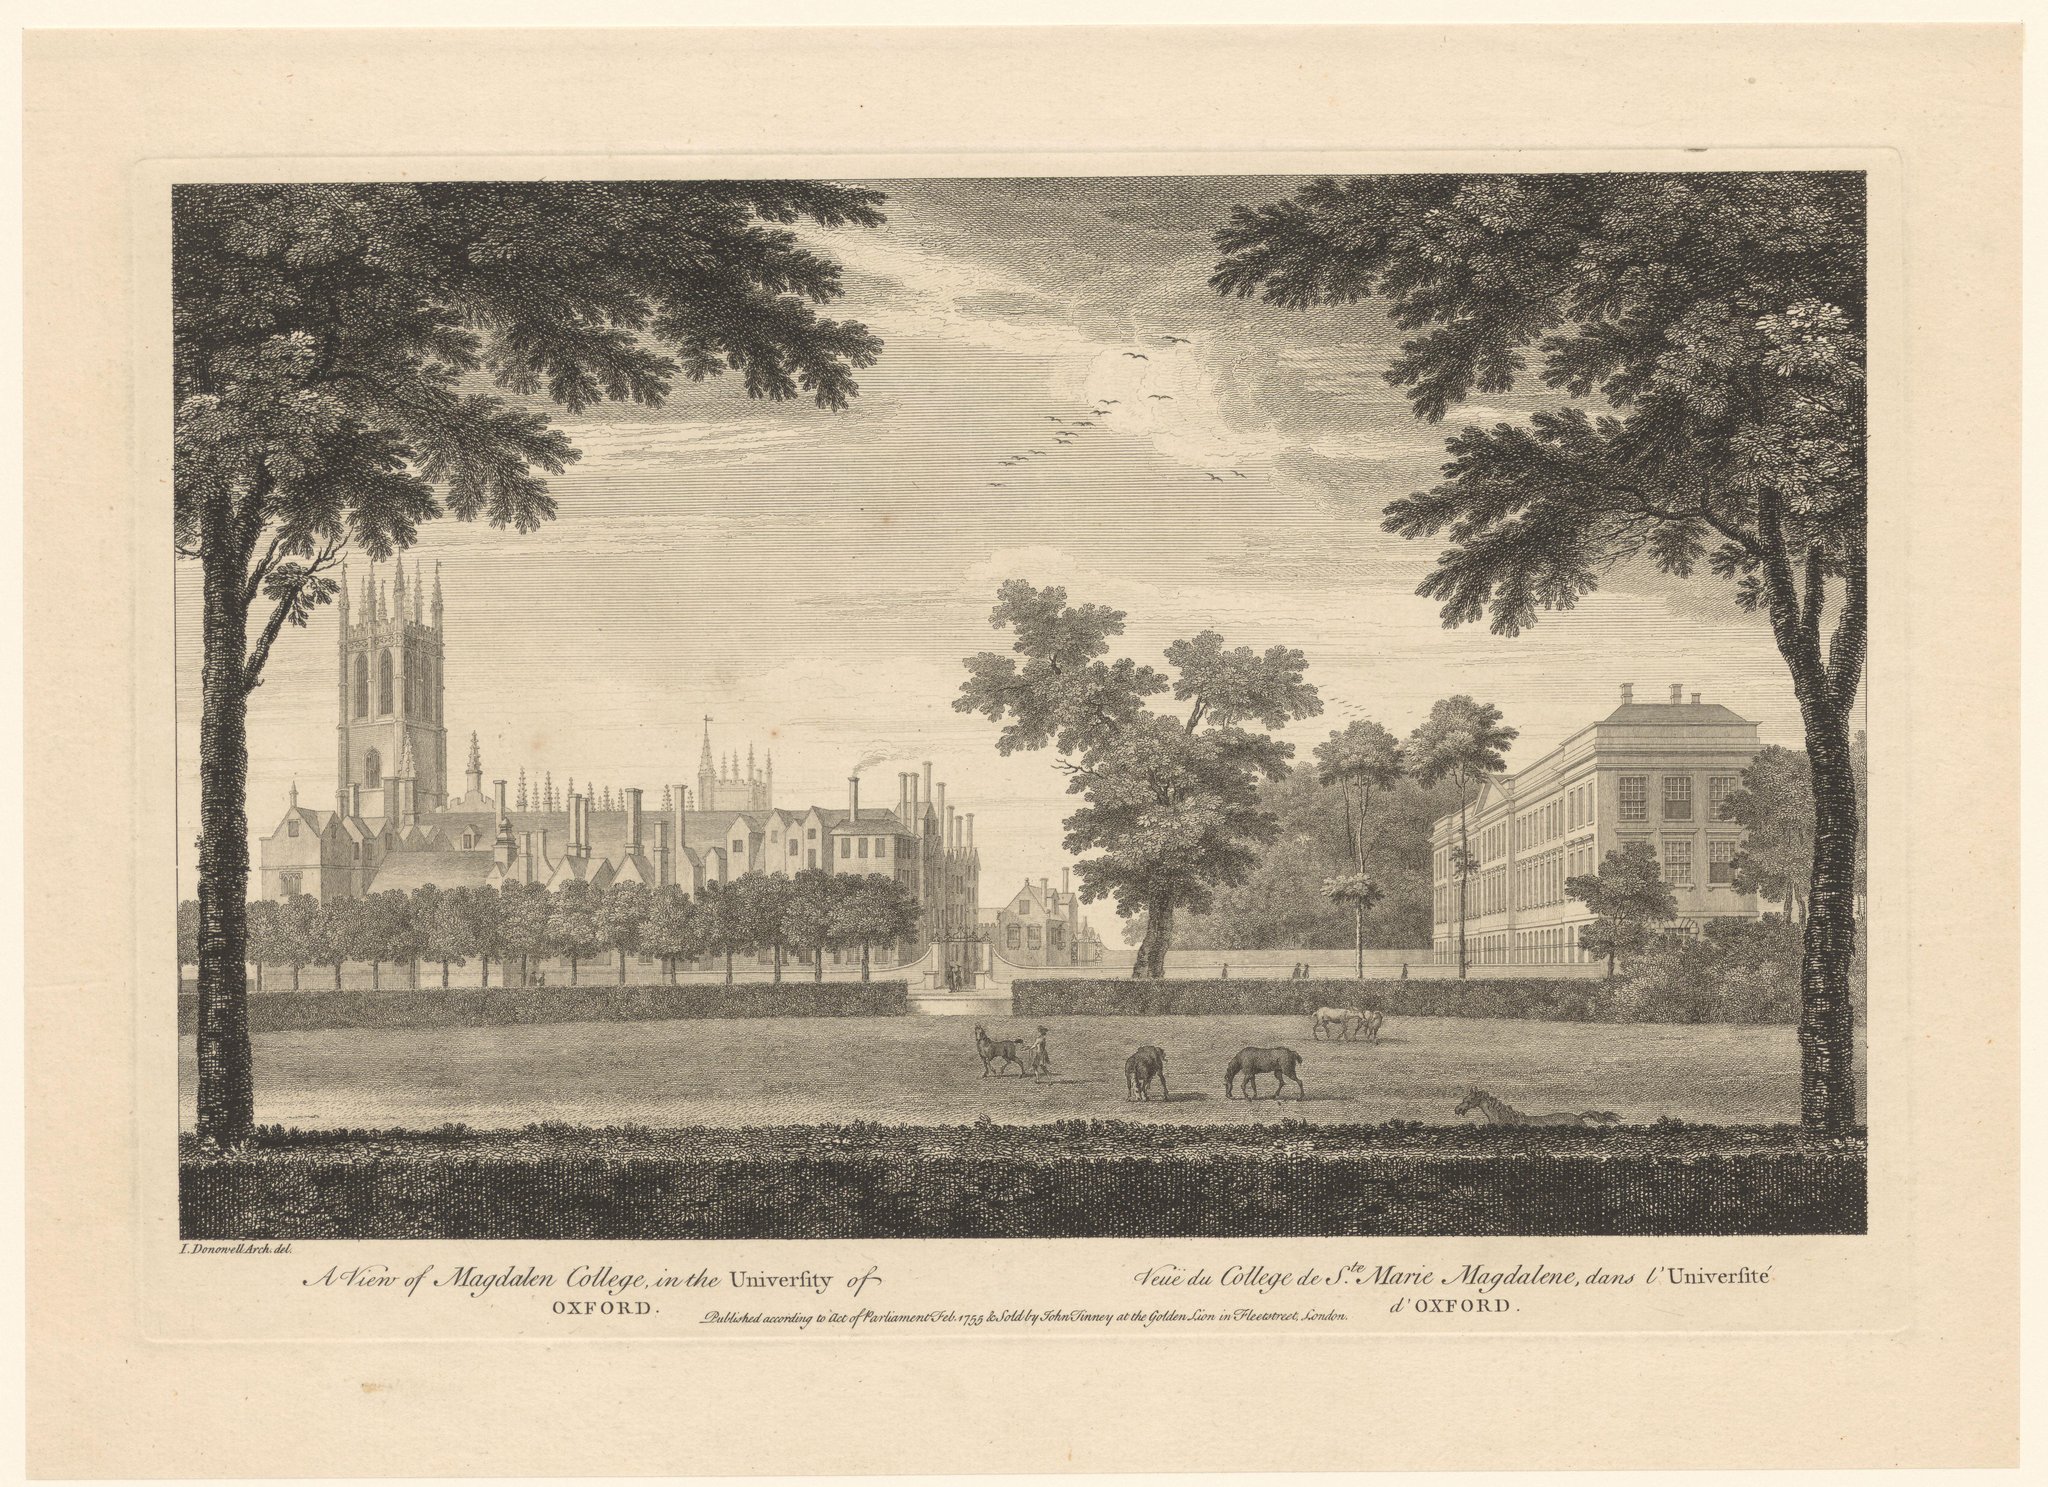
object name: print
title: Acht gezichten op Oxford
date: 1702-1755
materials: paper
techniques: etching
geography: london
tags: city-view in general; 'veduta', university building, college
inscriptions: collector's mark: Lugt 2228